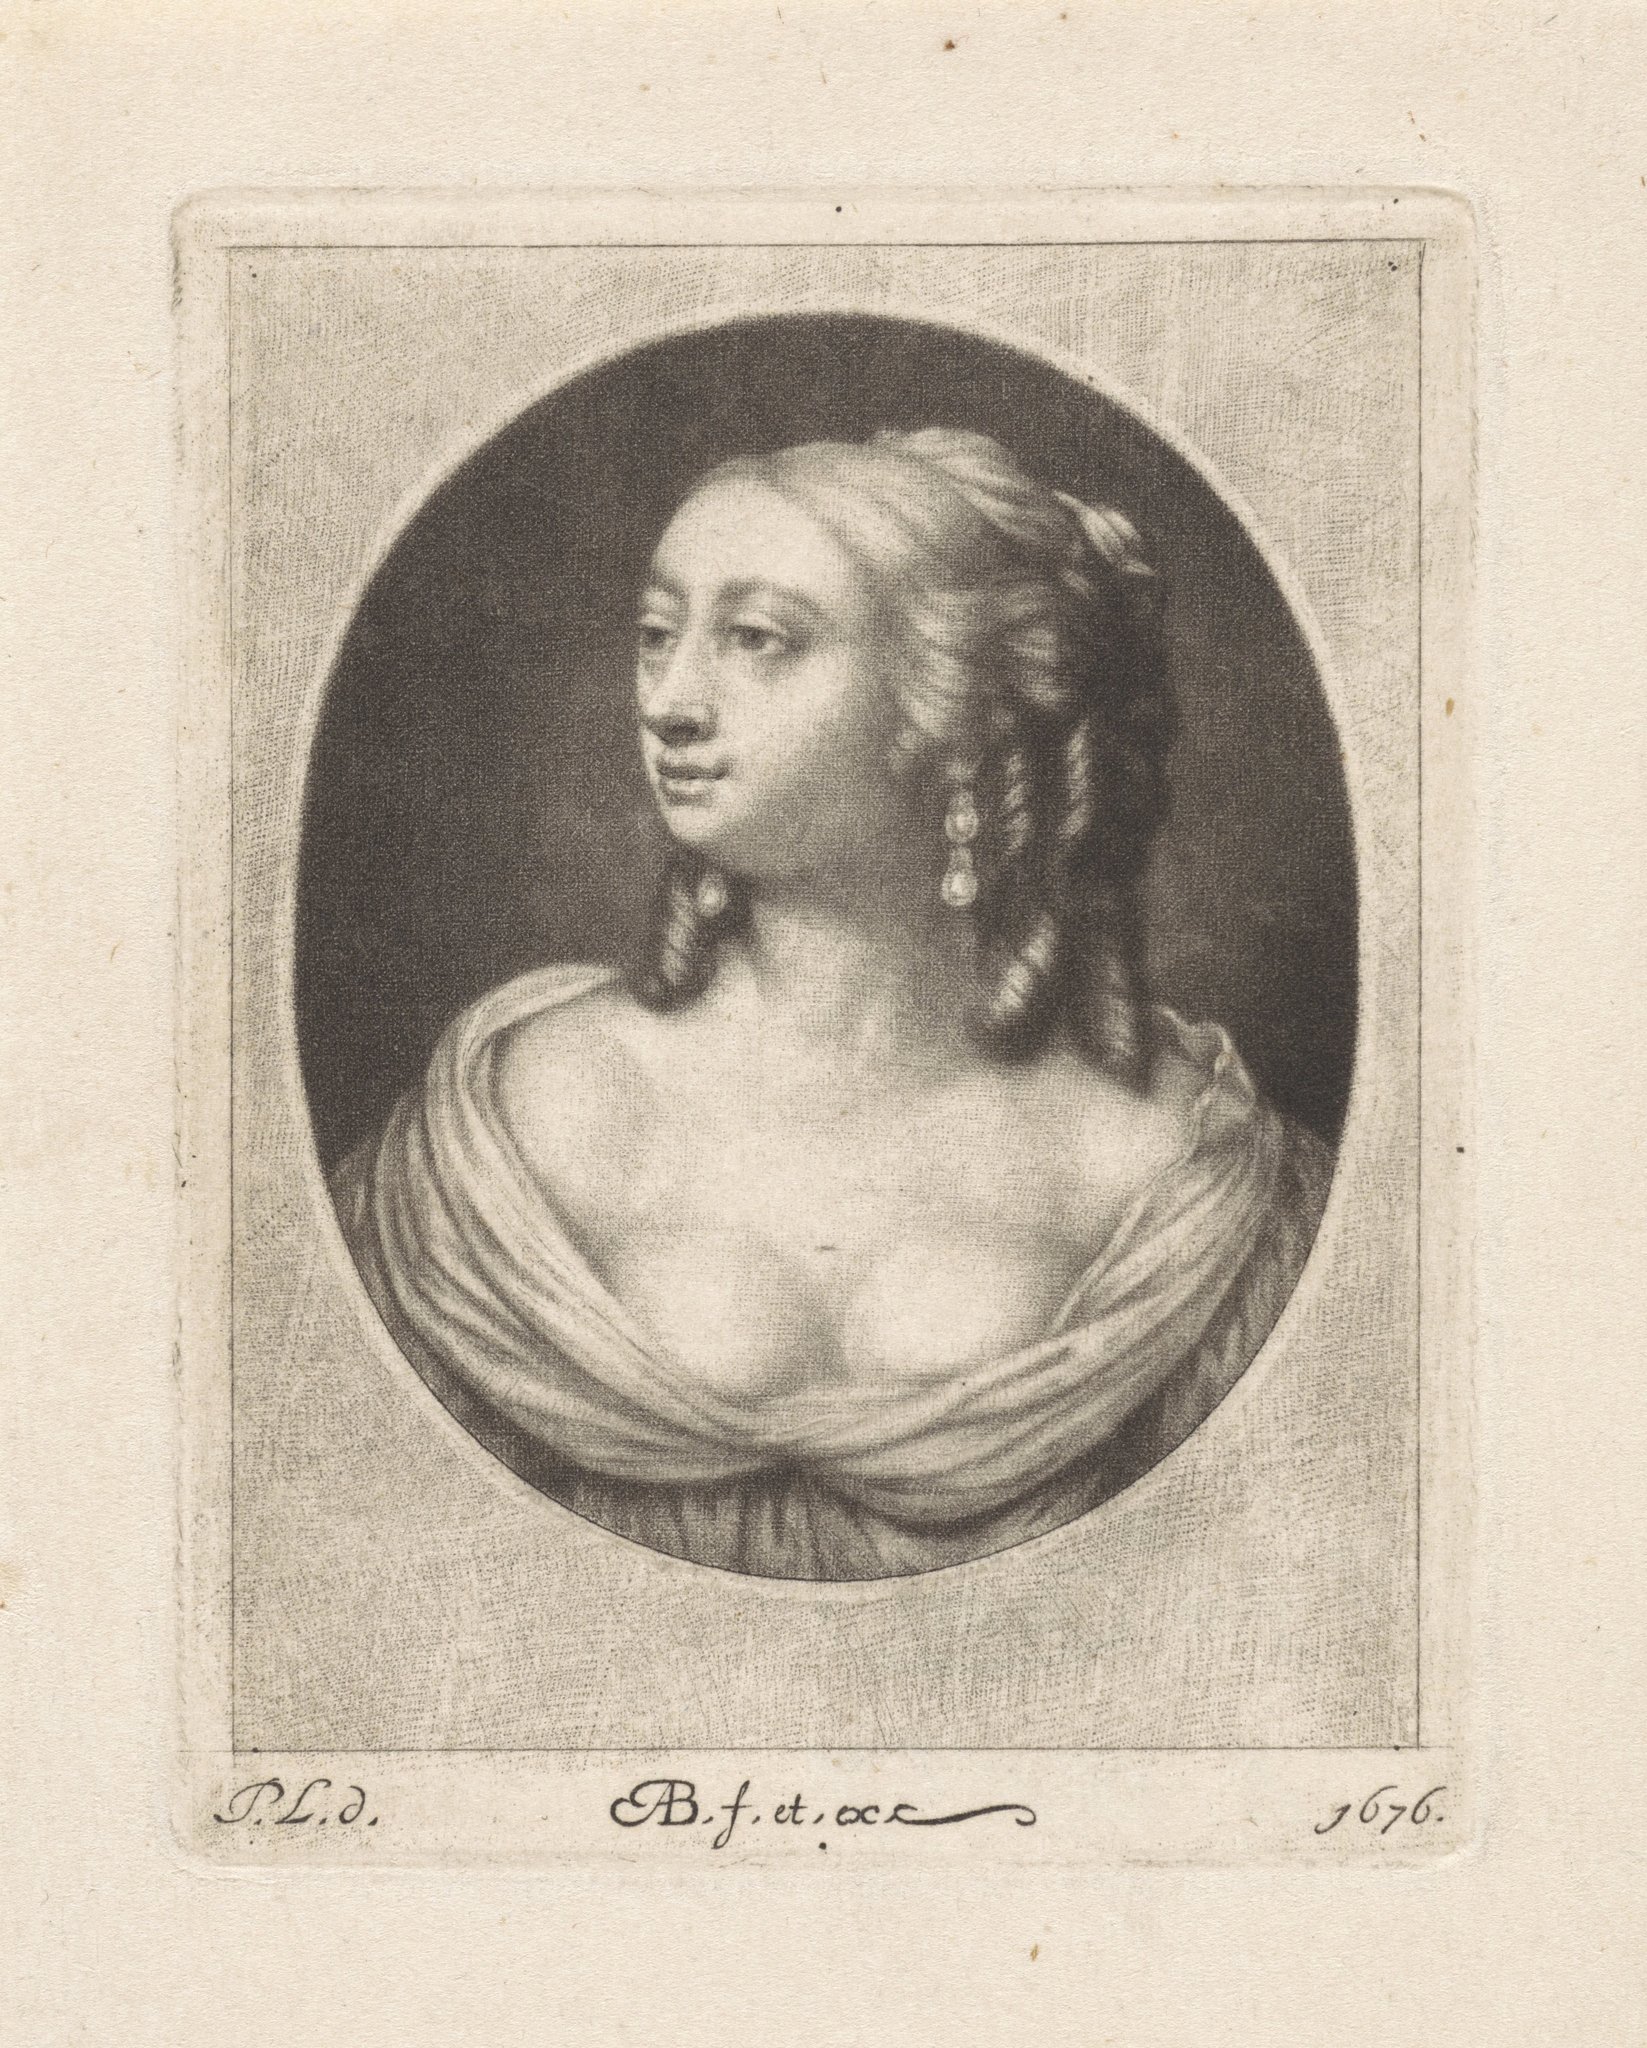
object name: print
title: Buste van een jonge vrouw met half ontblote boezem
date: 1676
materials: paper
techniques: mezzotint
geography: london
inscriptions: collector's mark: Lugt 2228